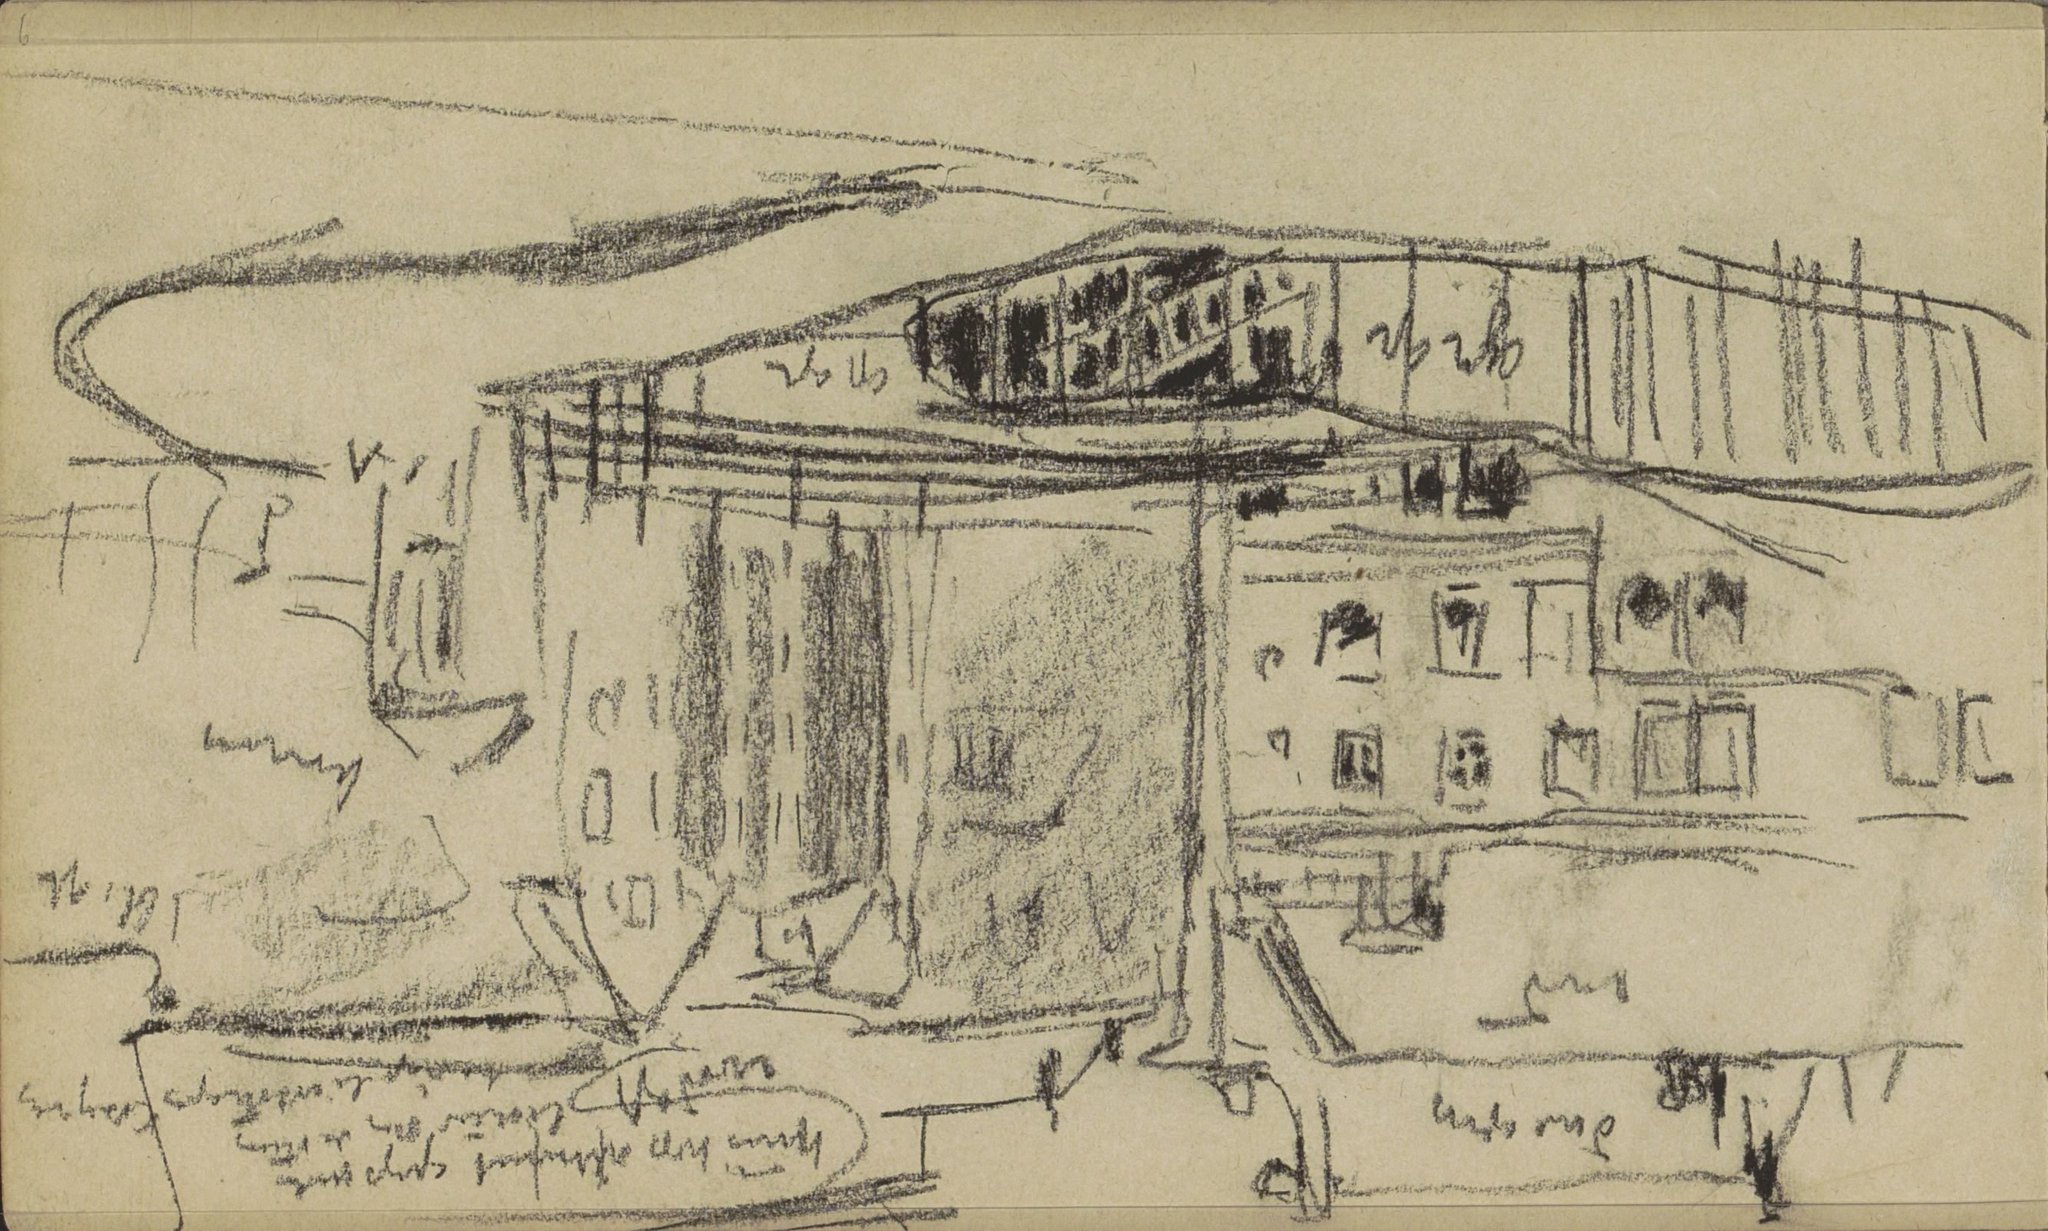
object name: sketchbook leaf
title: Gezicht op een brug in Amsterdam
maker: willem witsen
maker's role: draughtsman, painter, print maker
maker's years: 1860-1923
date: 1887-1897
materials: chalk, paper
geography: amsterdam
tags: bridge in city across river, canal, etc., civic architecture; edifices; dwellings, amsterdam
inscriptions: kleurnotitie, handgeschreven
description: Pagina 6 uit een schetsboek met 25 bladen.